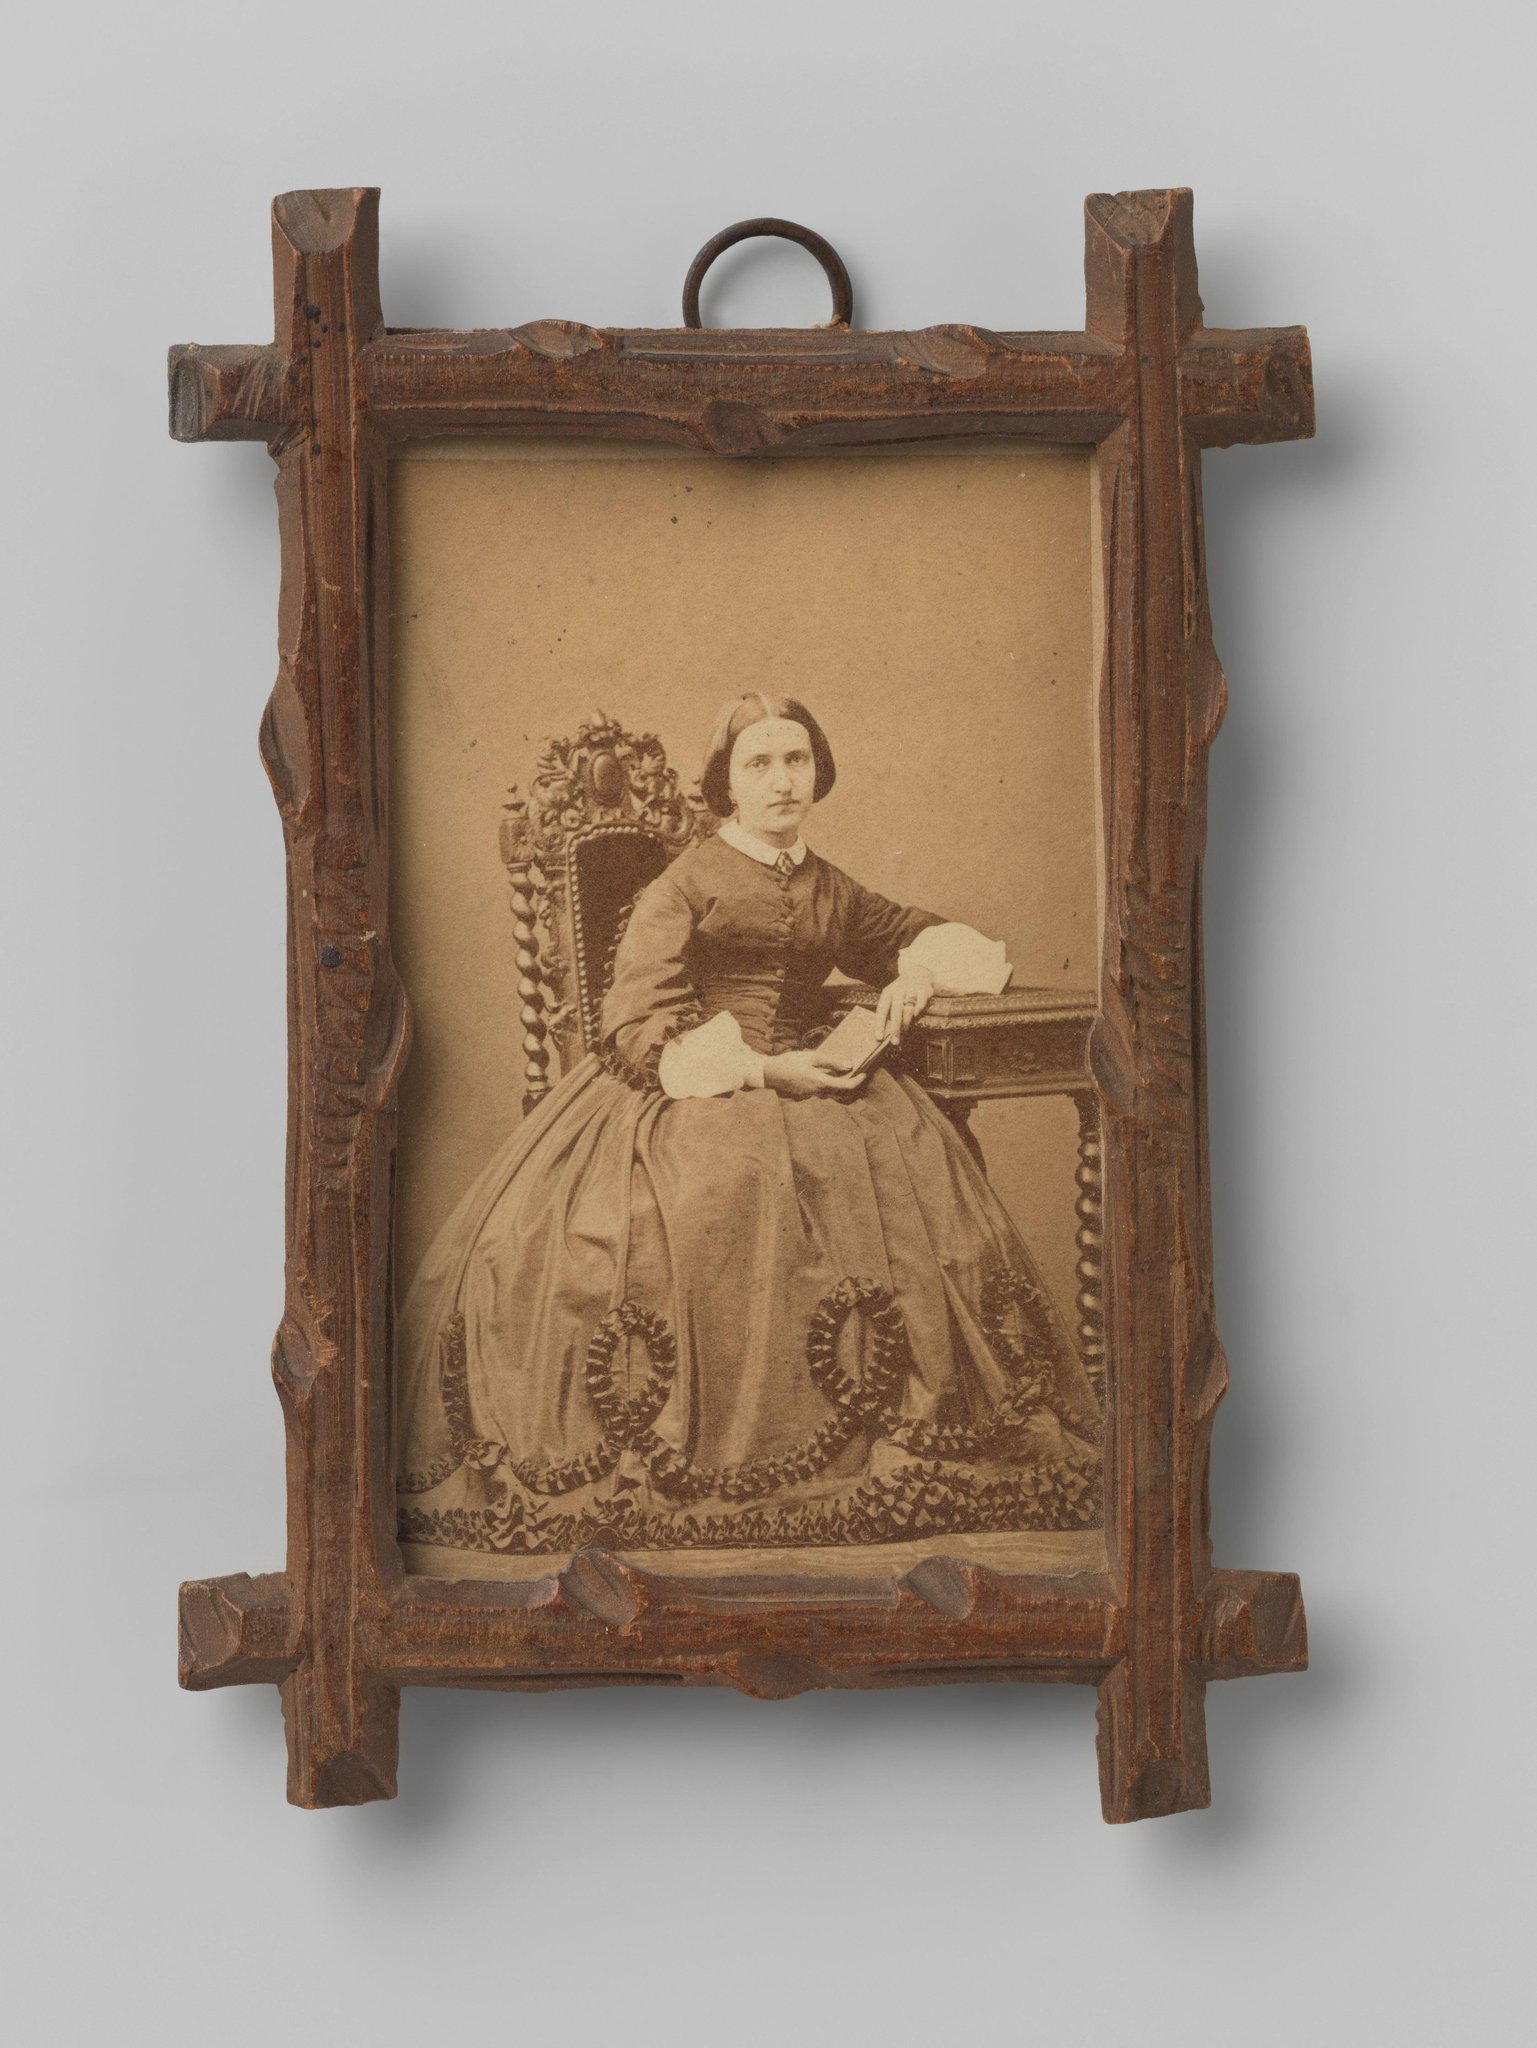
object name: carte de visite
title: Portret van een onbekende zittende vrouw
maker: Anonymous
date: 1880-1900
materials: glass, metal, paper, textile, wood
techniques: albumen print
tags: sitting figure, anonymous historical person portrayed - bb - woman